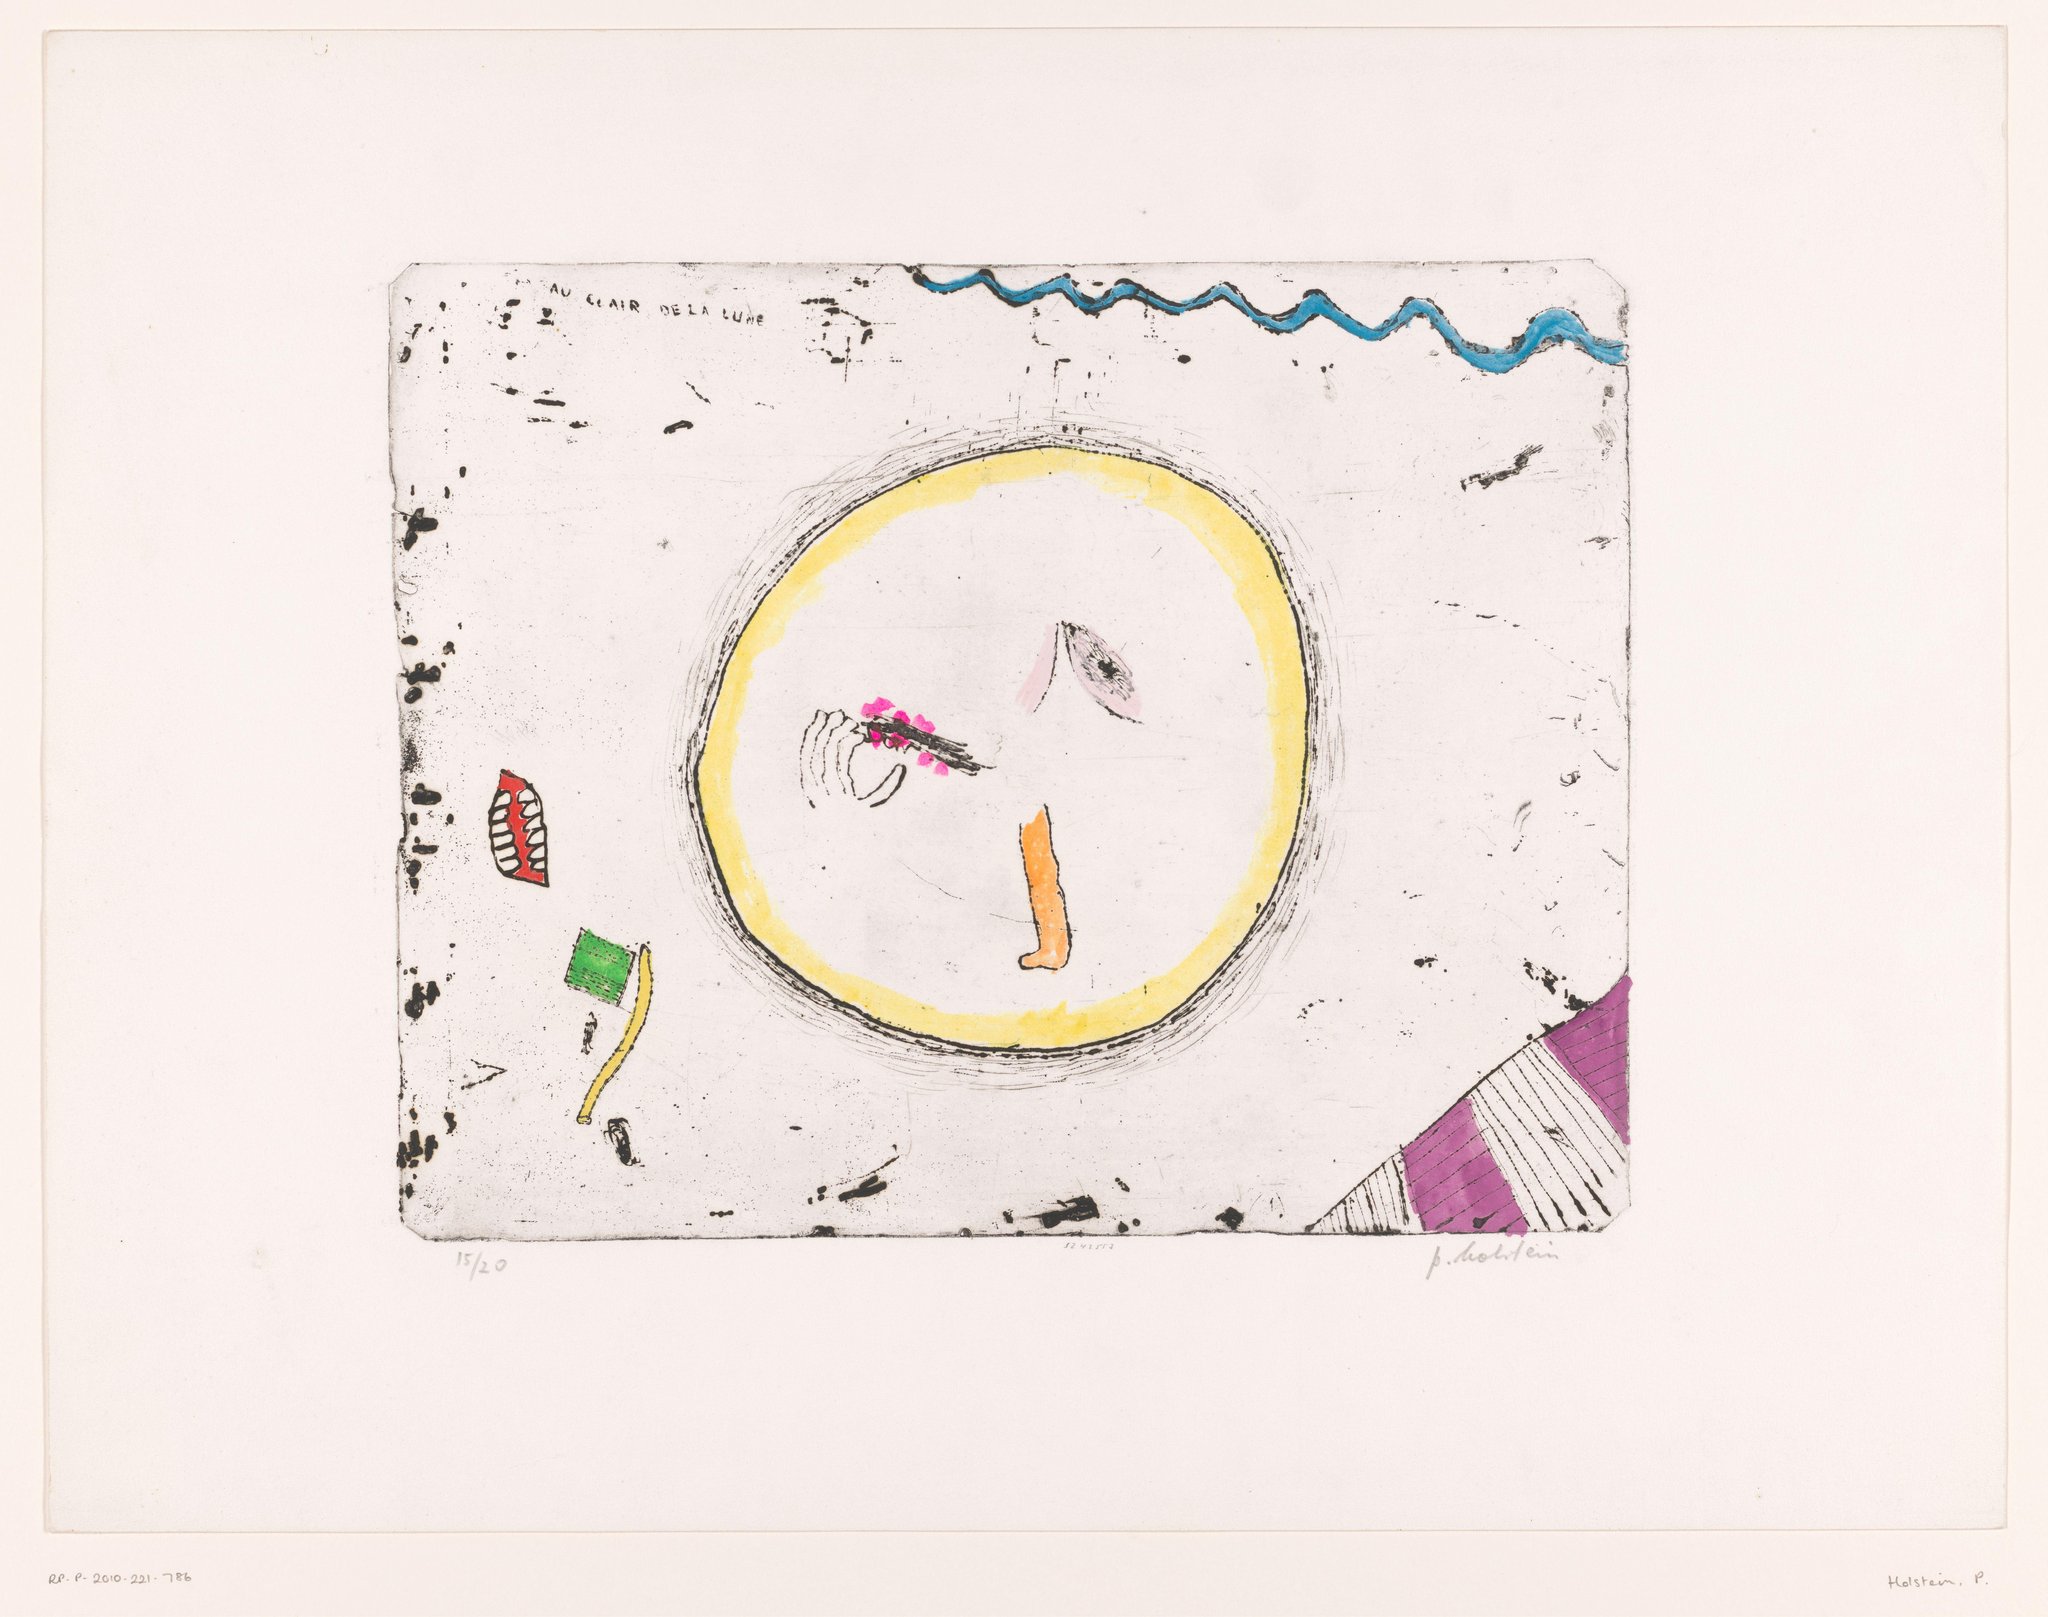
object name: print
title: Au clair de la lune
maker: pieter holstein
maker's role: draughtsman, painter, print maker, sculptor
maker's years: 1934-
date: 1967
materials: paper, watercolor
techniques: brush, etching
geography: amsterdam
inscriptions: signature: ‘p. holstein’, title: ‘AU CLAIR DE LA LUNE’, edition: ‘15/20’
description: Gele cirkel (maan) en links een geopende mond met tanden en een tandenborstel.